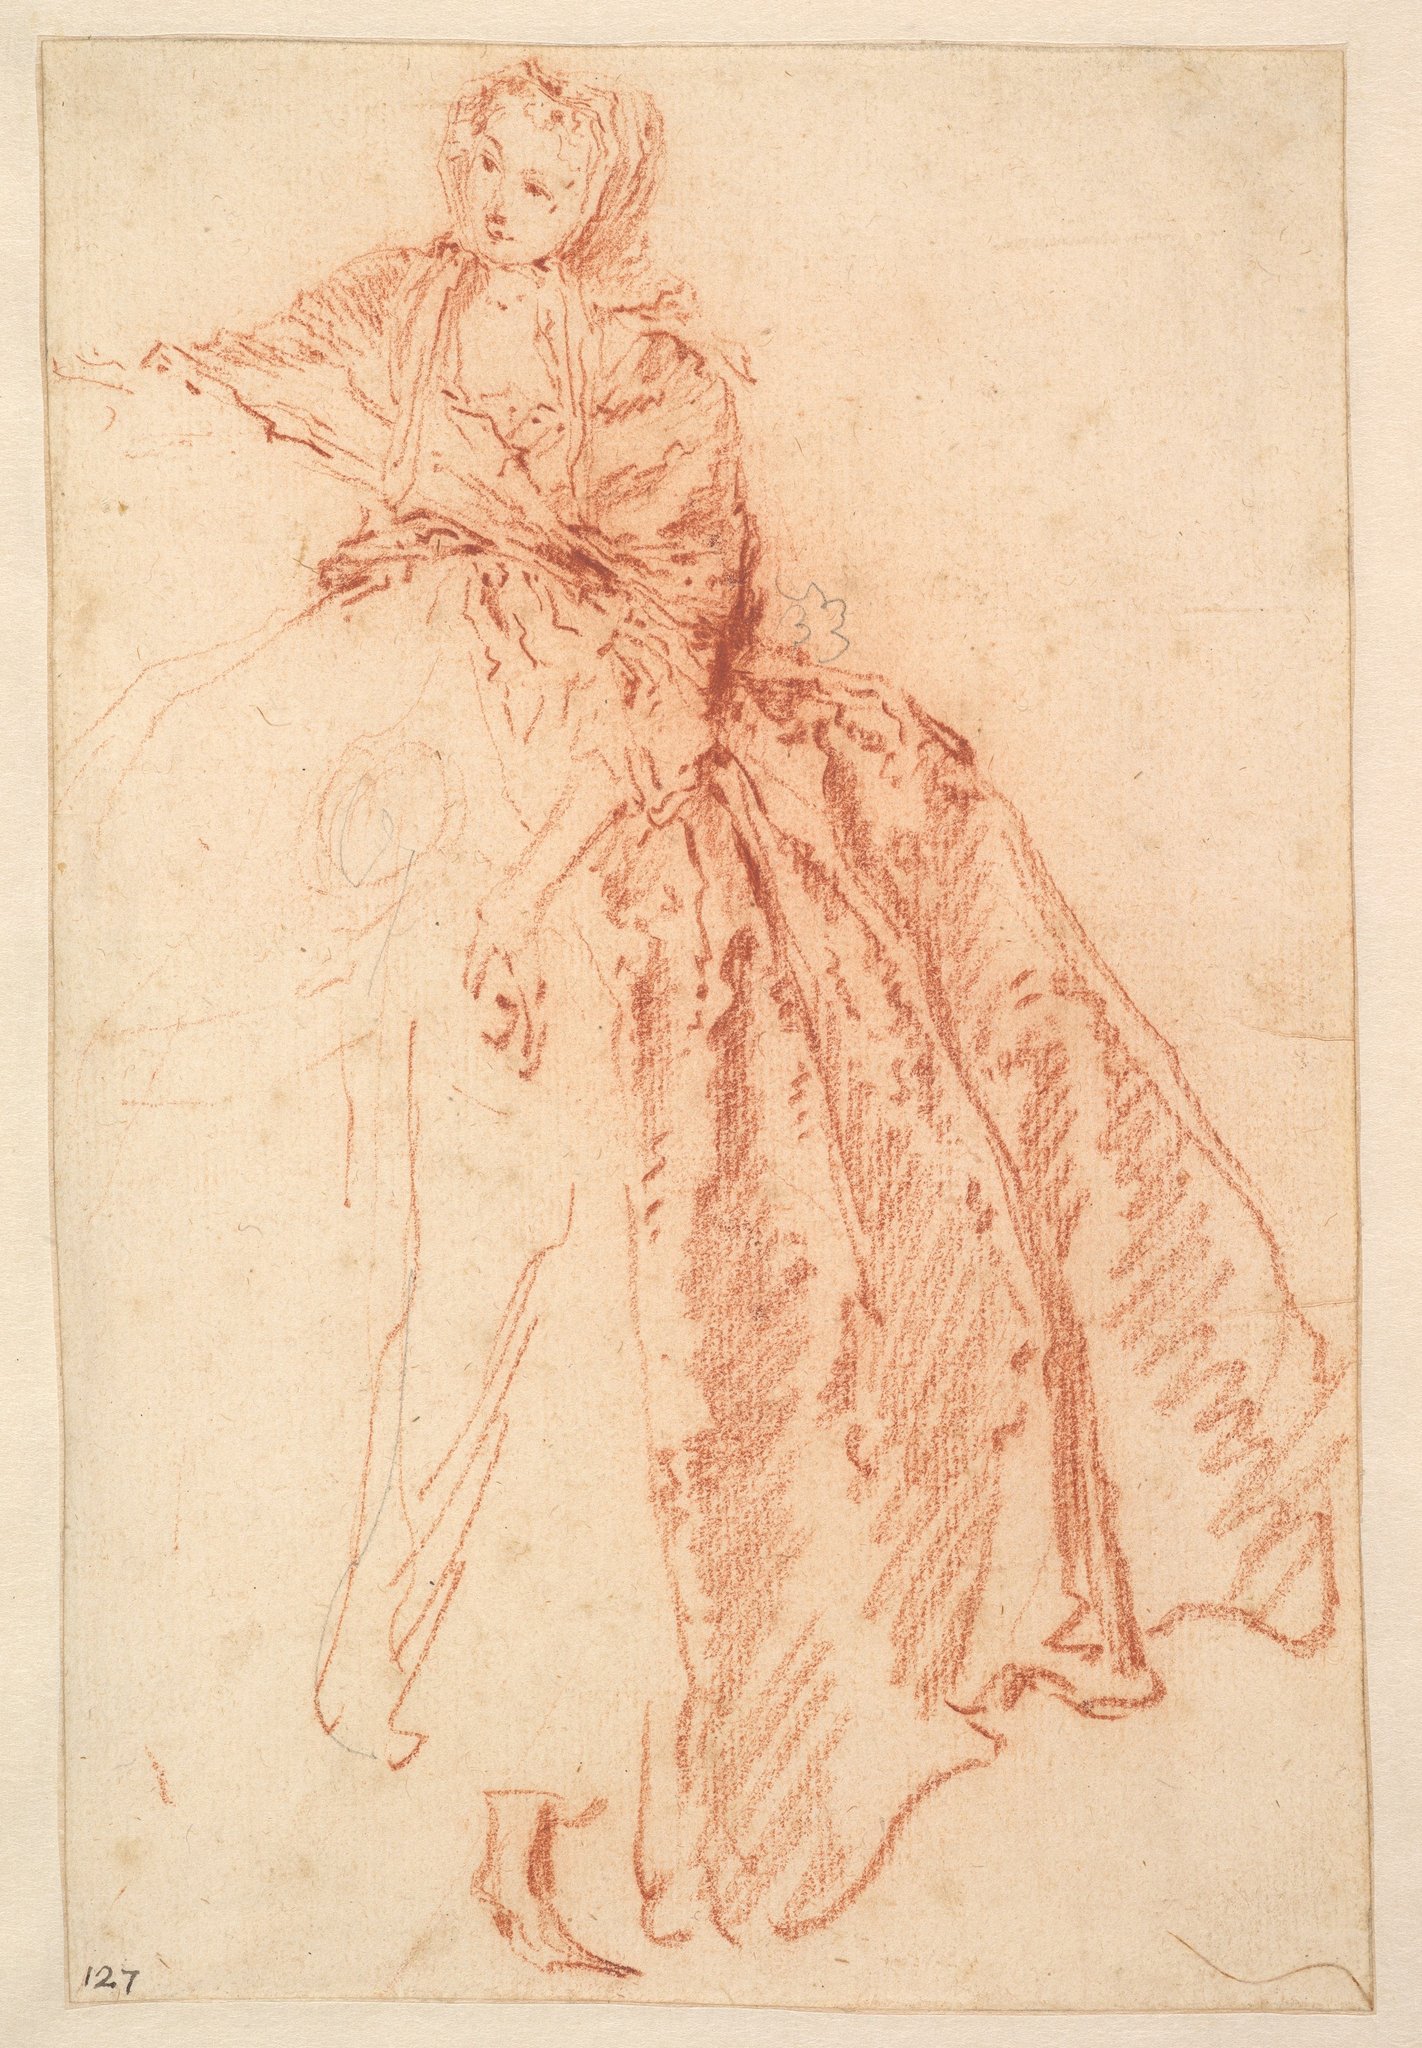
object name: drawing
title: Study for "M. de Pourceaugnac"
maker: jean-baptiste joseph pater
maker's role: artist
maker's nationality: french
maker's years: 1695-1736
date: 1701-1733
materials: chalk, graphite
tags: women